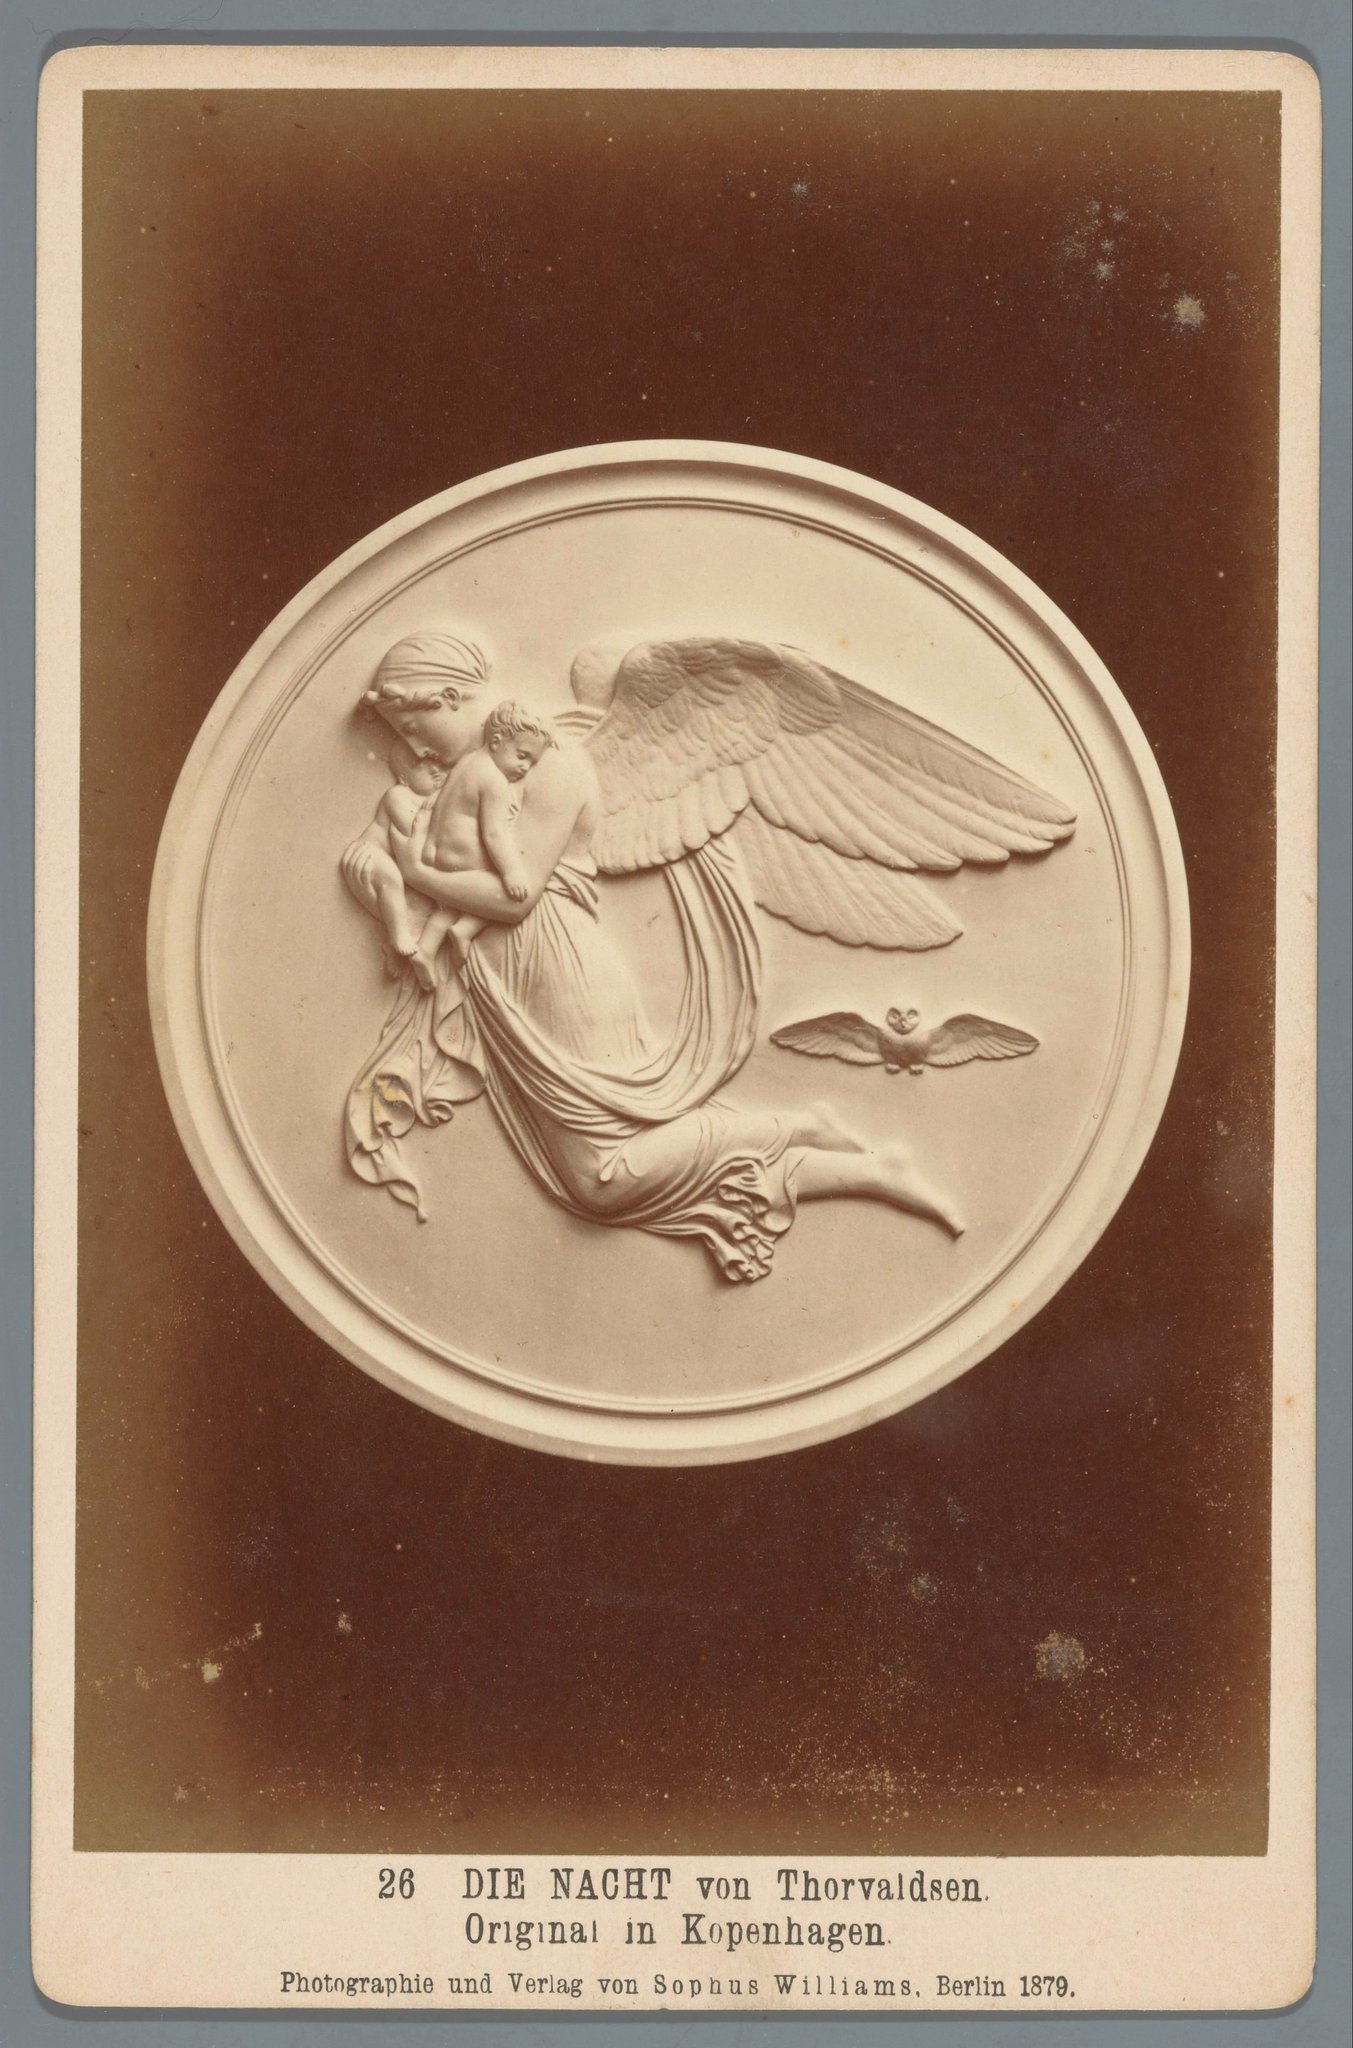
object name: cabinet photograph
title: Die Nacht von Thorvaldsen Original in Kopenhagen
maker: sophus williams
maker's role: publisher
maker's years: 1835-1900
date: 1879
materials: cardboard, photographic support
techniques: albumen print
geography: berlin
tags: night, sculpture (+ relief ~ sculpture)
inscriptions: number: ‘26’